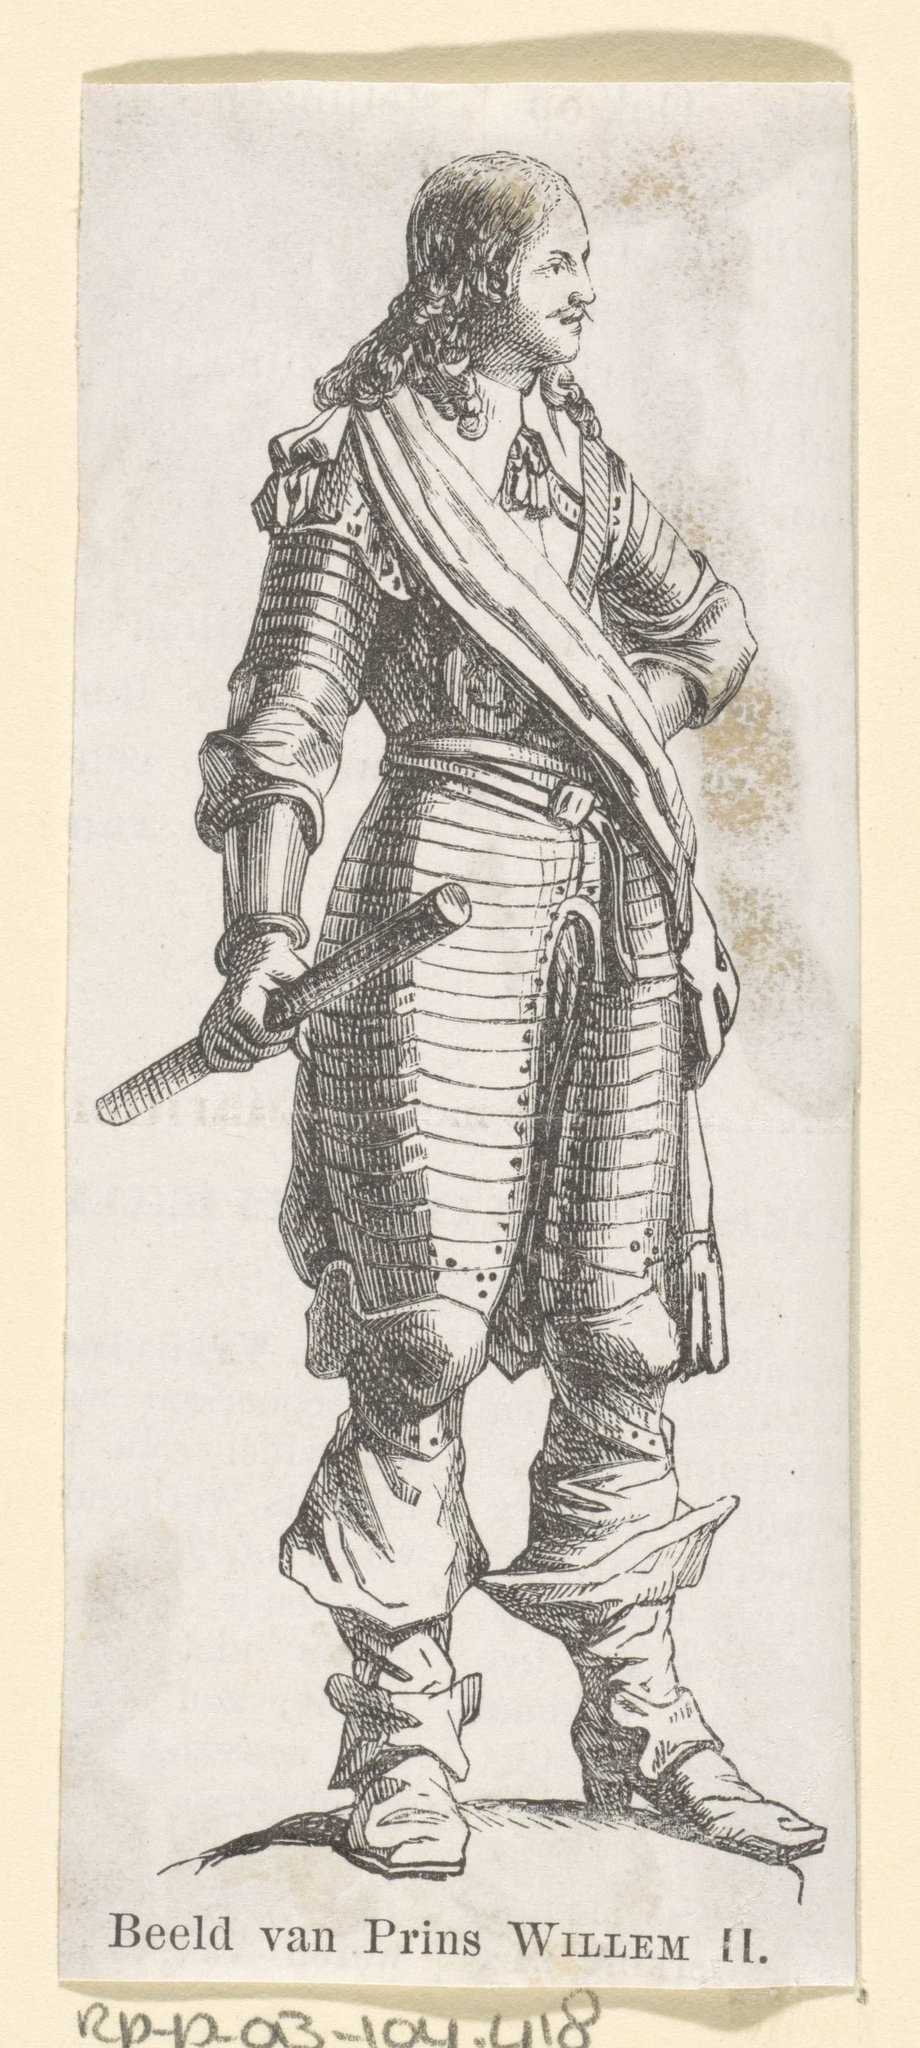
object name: book illustration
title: Standbeeld van Willem II, prins van Oranje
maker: Anonymous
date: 1800-1899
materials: paper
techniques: letterpress printing, engraving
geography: low countries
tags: william ii (prince of orange), monument, statue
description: De hier vermelde titel verwijst naar de hoogst verkregen titel van de geportretteerde, niet per se naar de titel die de geportretteerde op deze voorstelling draagt.